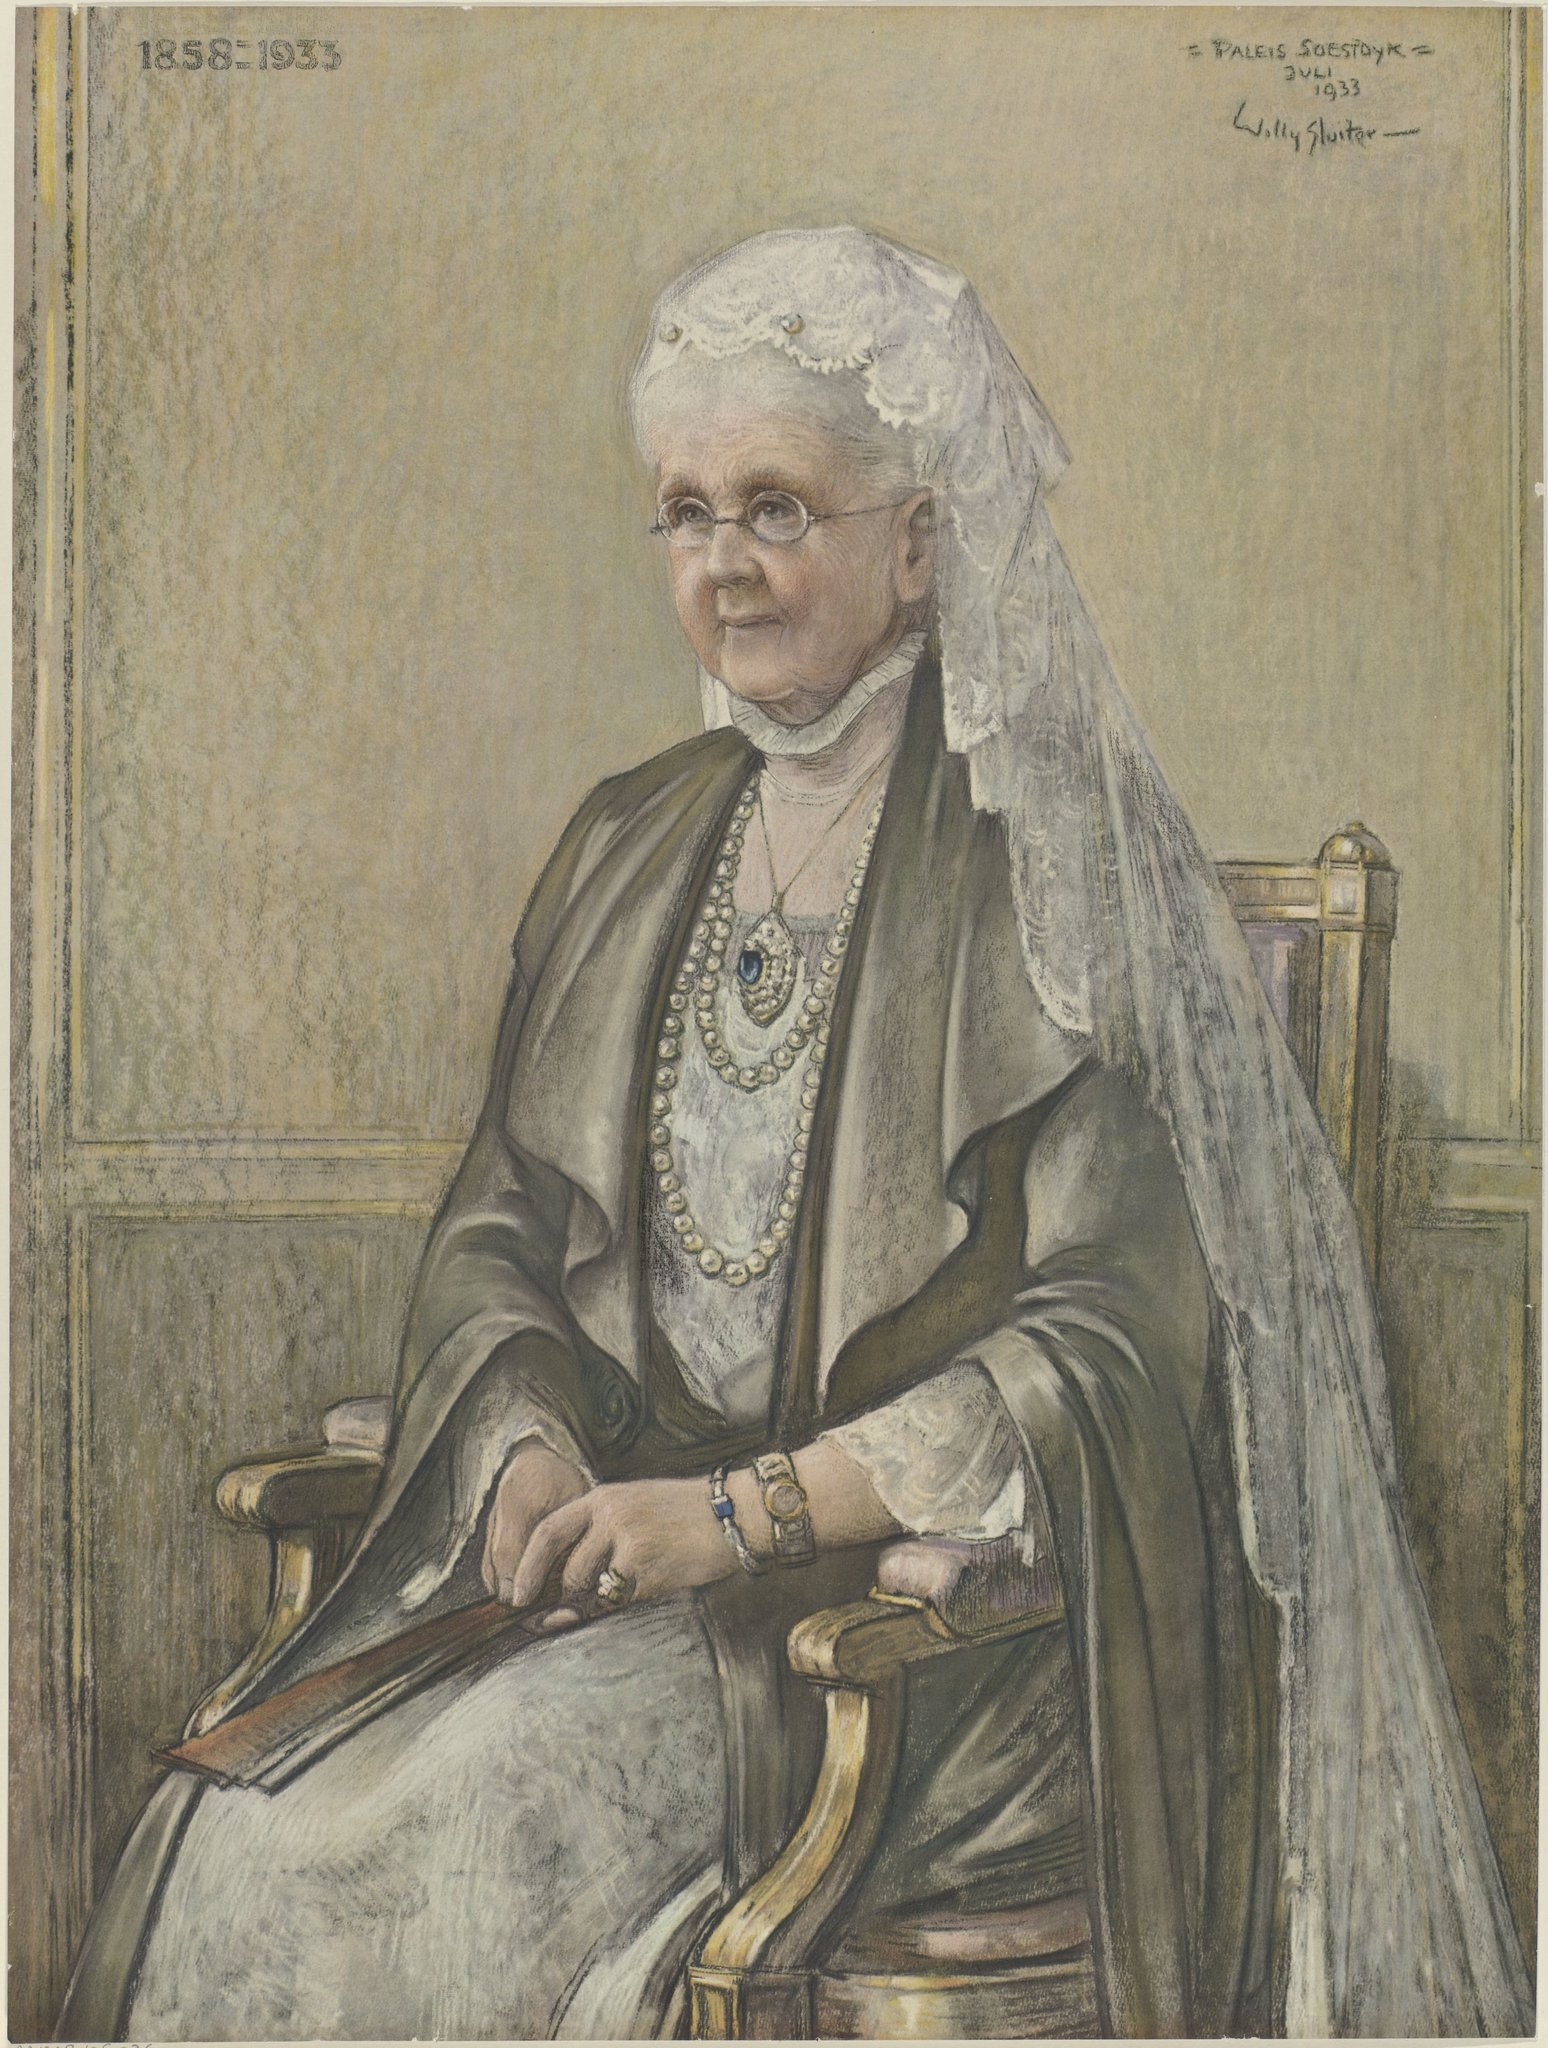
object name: print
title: Portret van Emma, koningin-regentes der Nederlanden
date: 1933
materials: paper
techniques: offset printed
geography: netherlands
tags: emma (queen consort of the netherlands)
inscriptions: collector's mark: Lugt 2228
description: Portret van Emma. Ze zit in een stoel met in haar handen een waaier. Linksboven de jaartallen '1858-1933'. Vervaardigd ter gelegenheid van de viering van de vijfenzeventigste verjaardag van Emma op 2 augustus 1933.